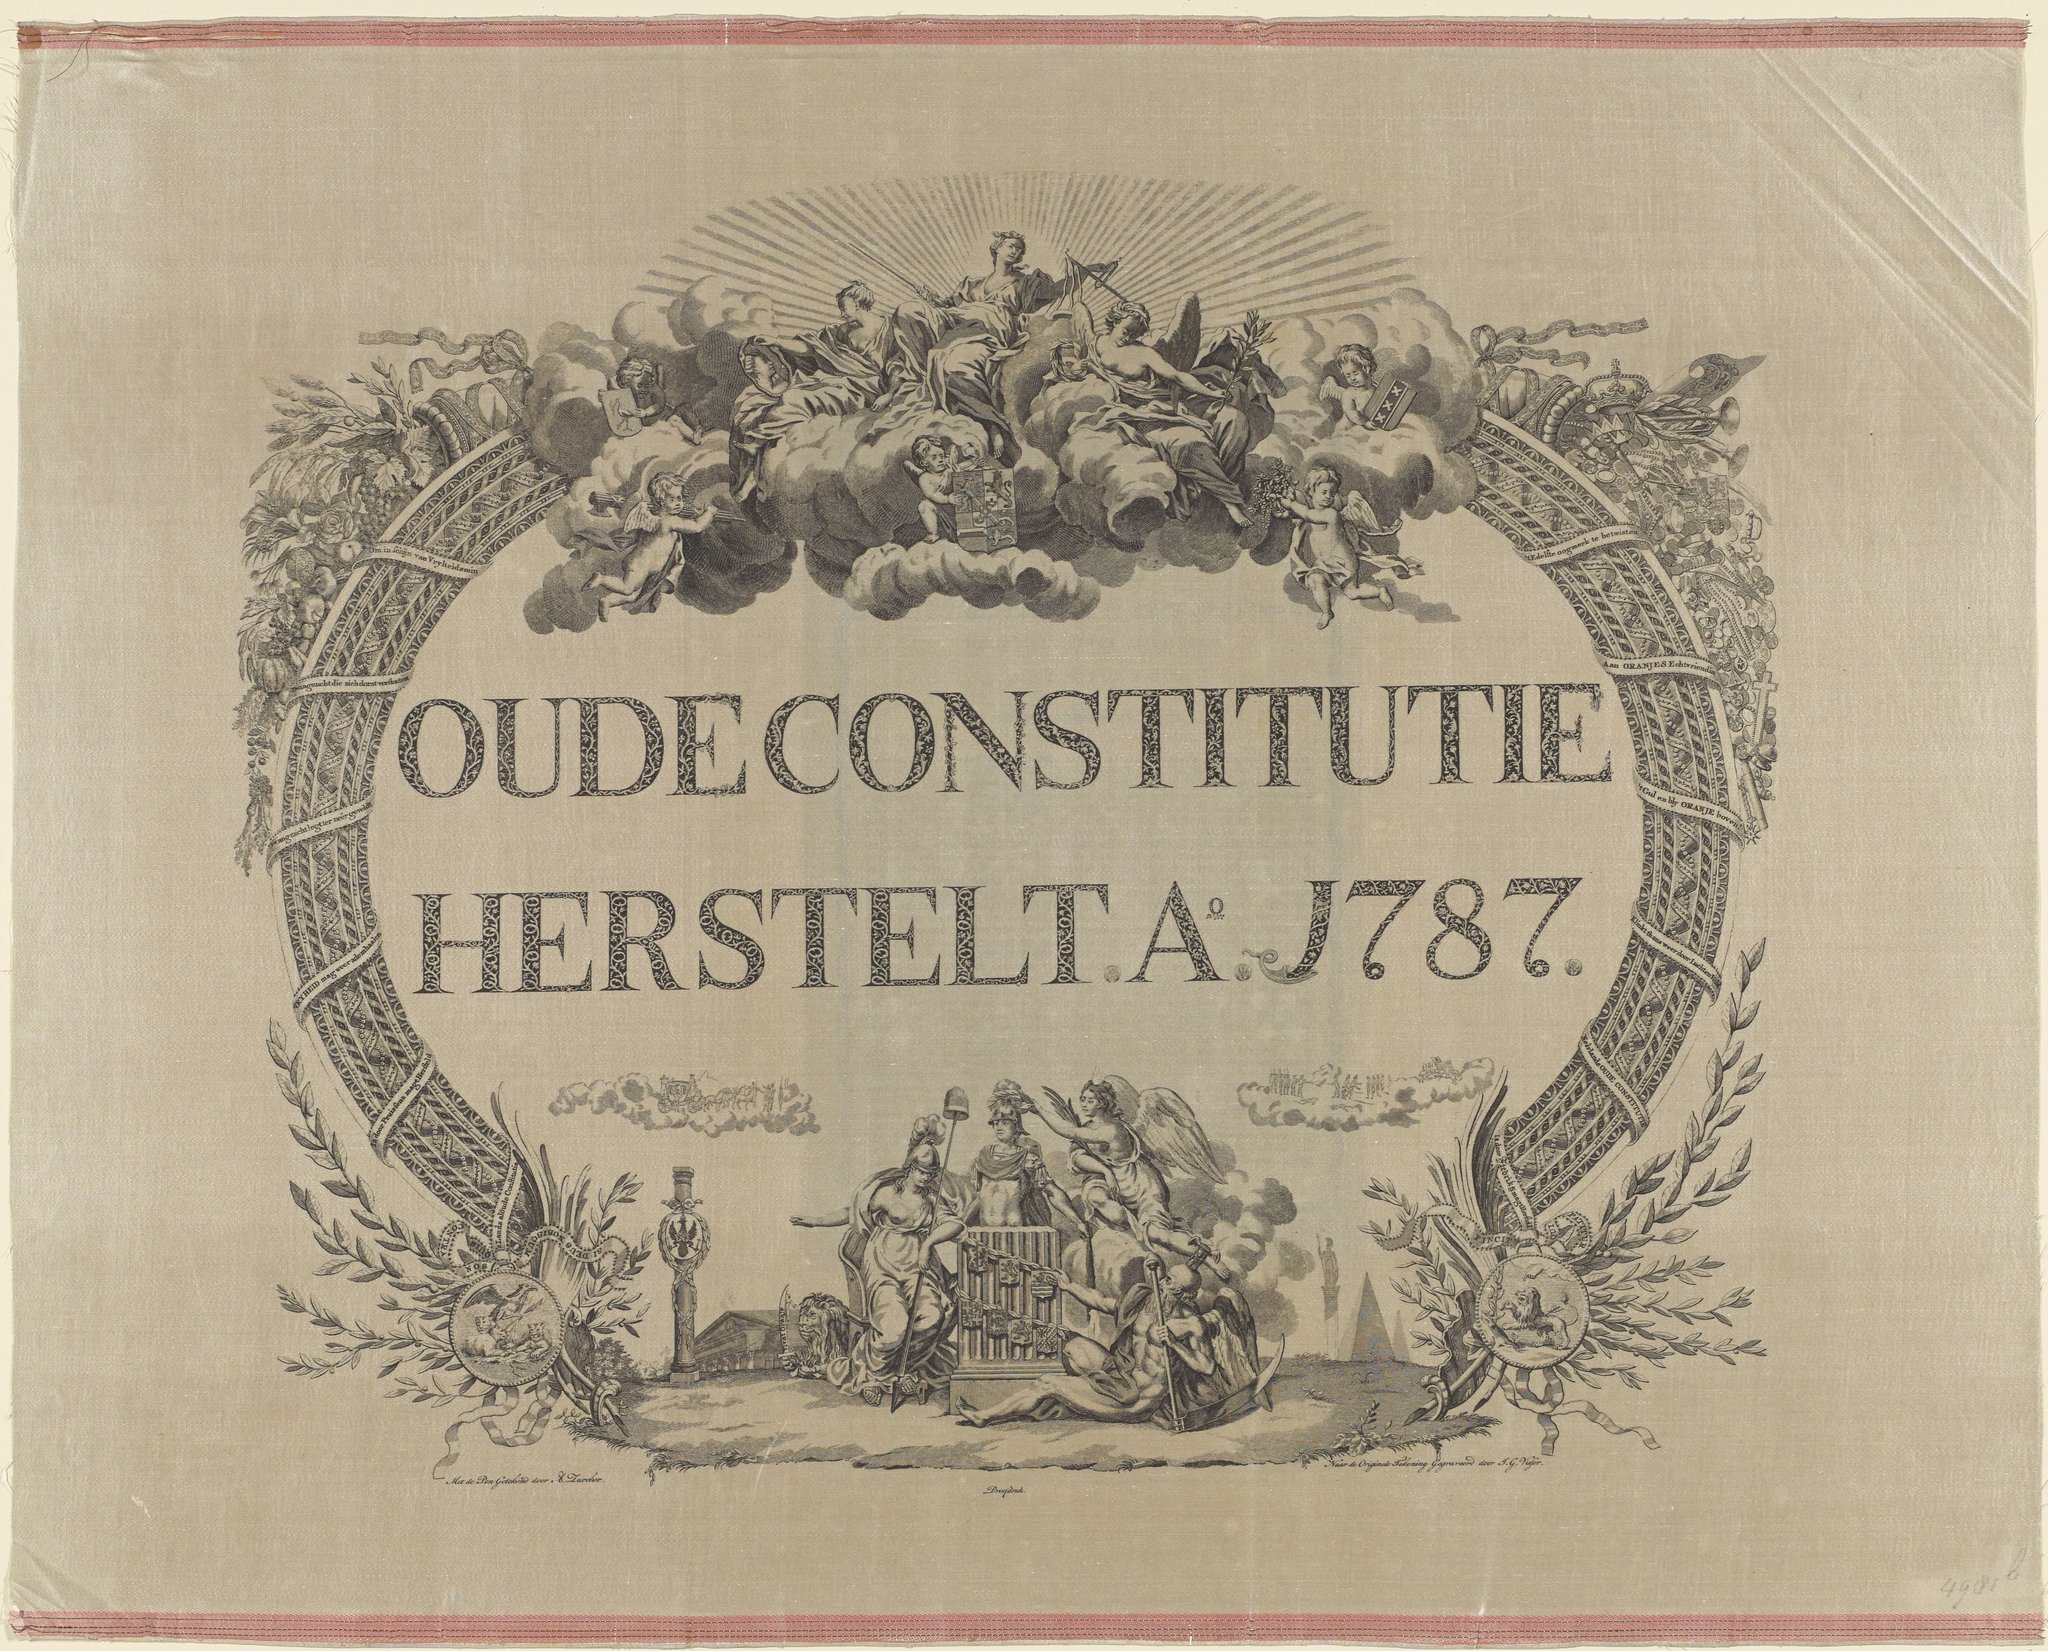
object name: print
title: Oude Constitutie Herstelt. Ao. 1787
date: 1787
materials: textile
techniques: engraving, etching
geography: northern netherlands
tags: justice, 'justitia'; 'giustitia divina' (ripa) ~ one of the four cardinal virtues, symbols, allegories of peace, 'pax'; 'pace' (ripa), father time, man with wings and scythe, freedom, liberty; 'libertà' (ripa) (+ abstract concept represented by female figure)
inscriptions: collector's mark: Lugt 2228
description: Allegorie op het herstel van stadhouder Willem V in 1787 door het ingrijpen van de Pruisische troepen. Kalligrafisch opschrift met allegorische vignetten. Bovenaan voor de stralende zon zit Gerechtigheid met Voorzichtigheid en Vrede. Links en rechts hoornen van overvloed waaruit vruchten en rijkdommen stromen. Onderaan een vignet met de Vrijheid en de Vader Tijd. Gedrukt op satijn met onder en boven gestikte roze linten. Bij de prent behoort een verklaring.